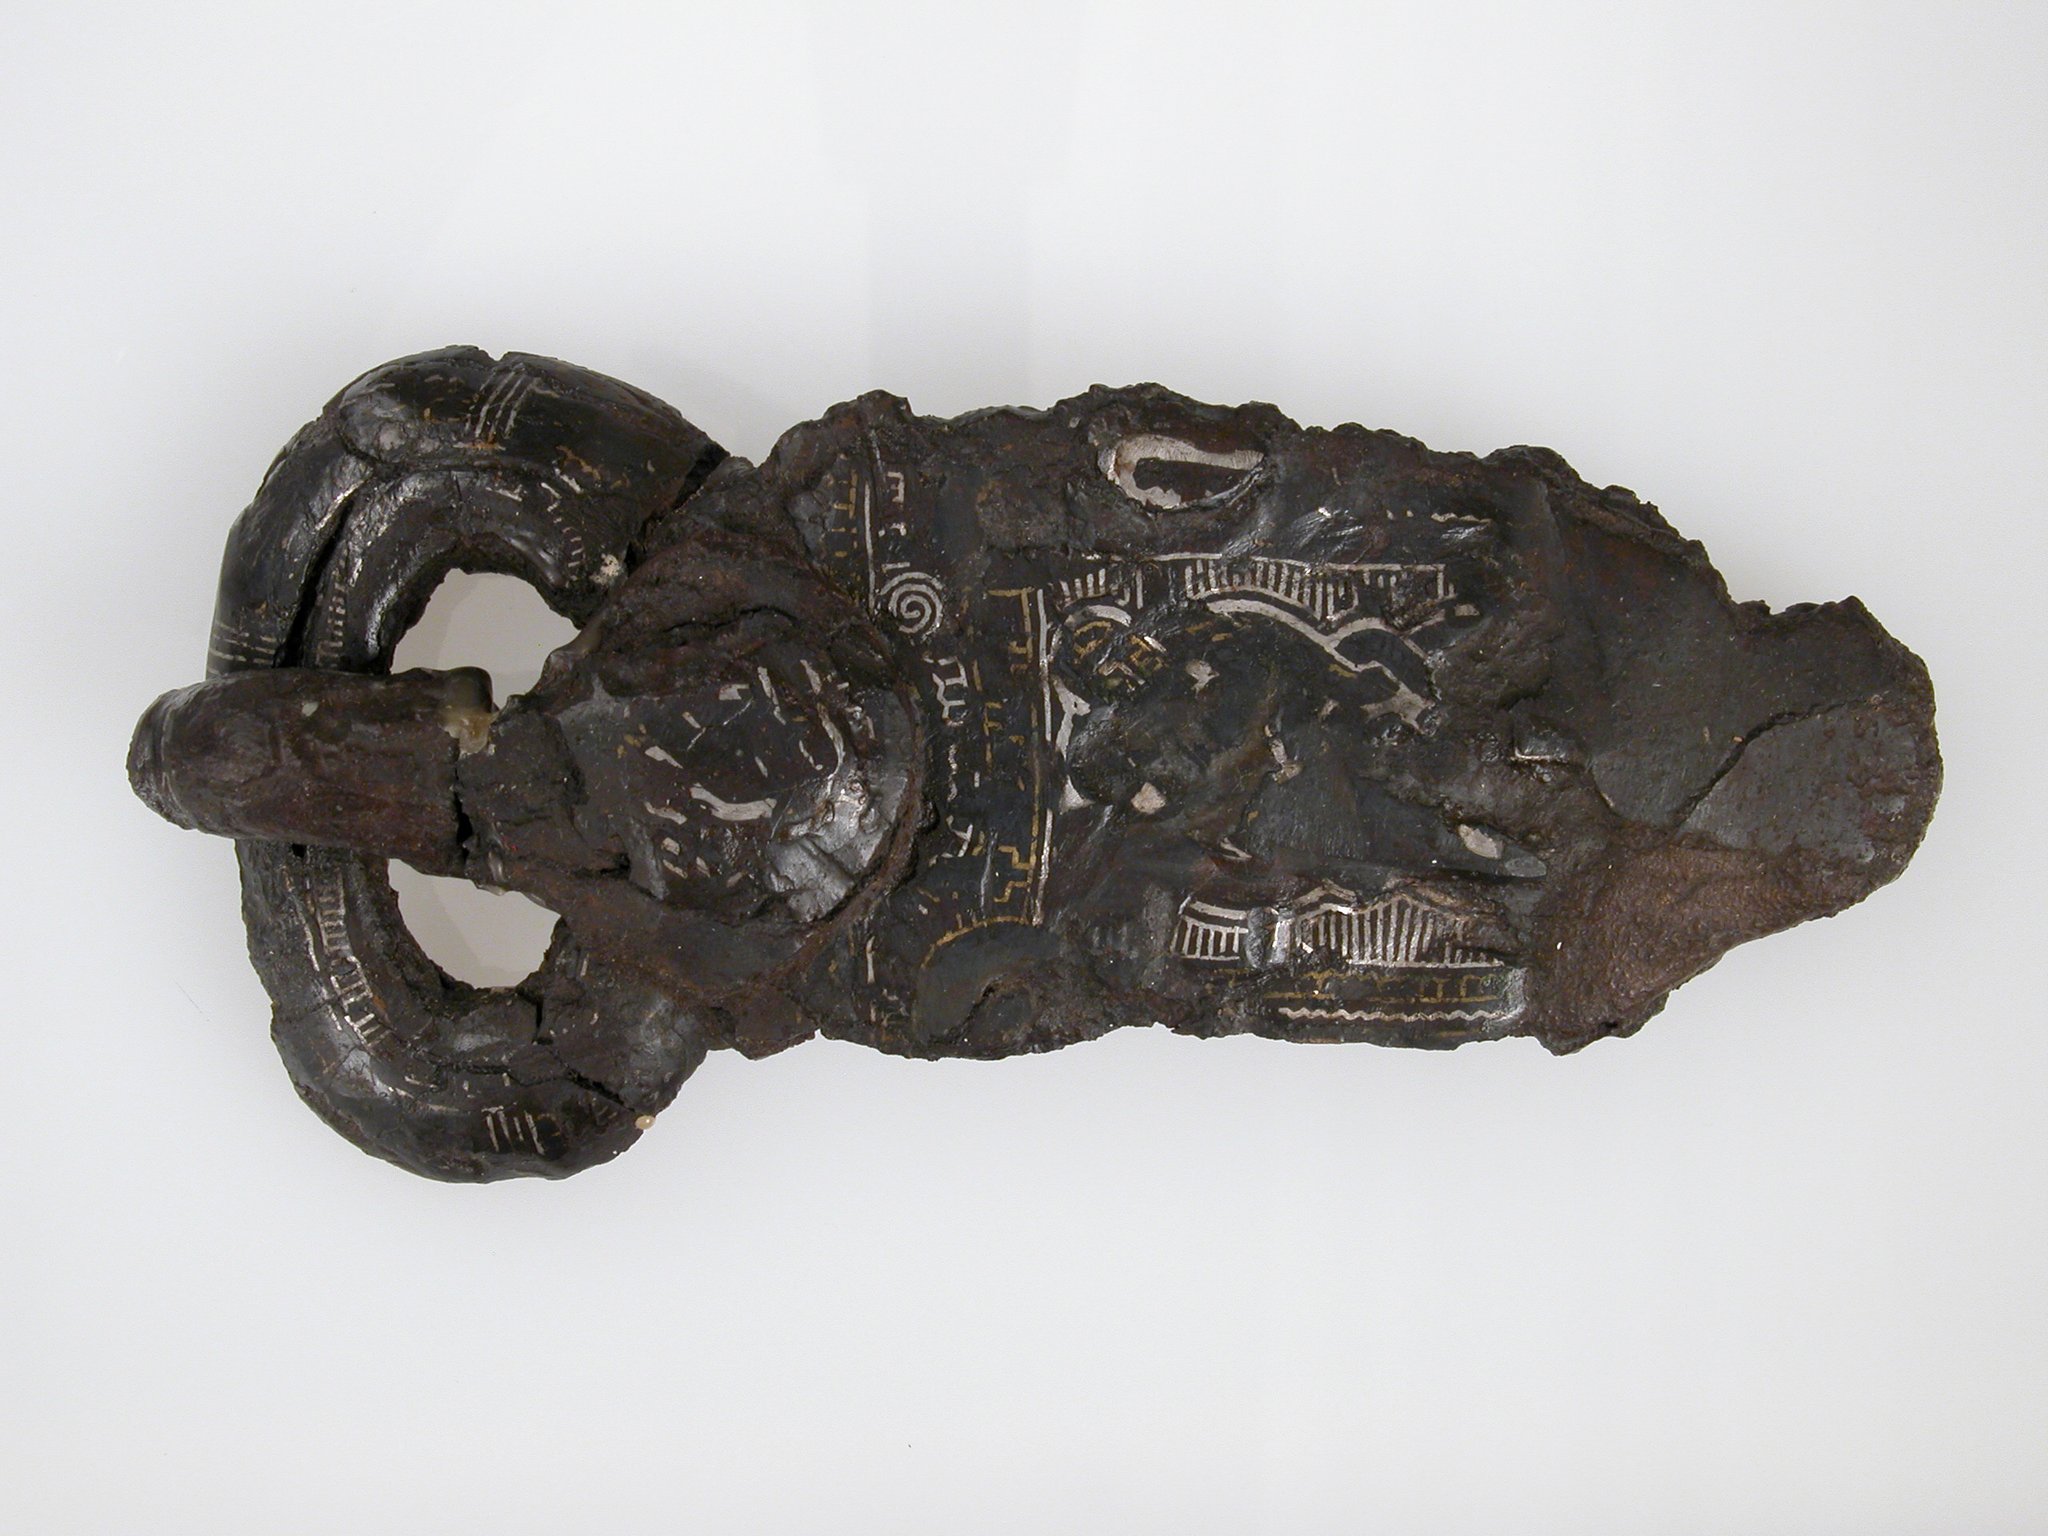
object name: belt buckle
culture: frankish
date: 601-700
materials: brass, iron, silver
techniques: inlay